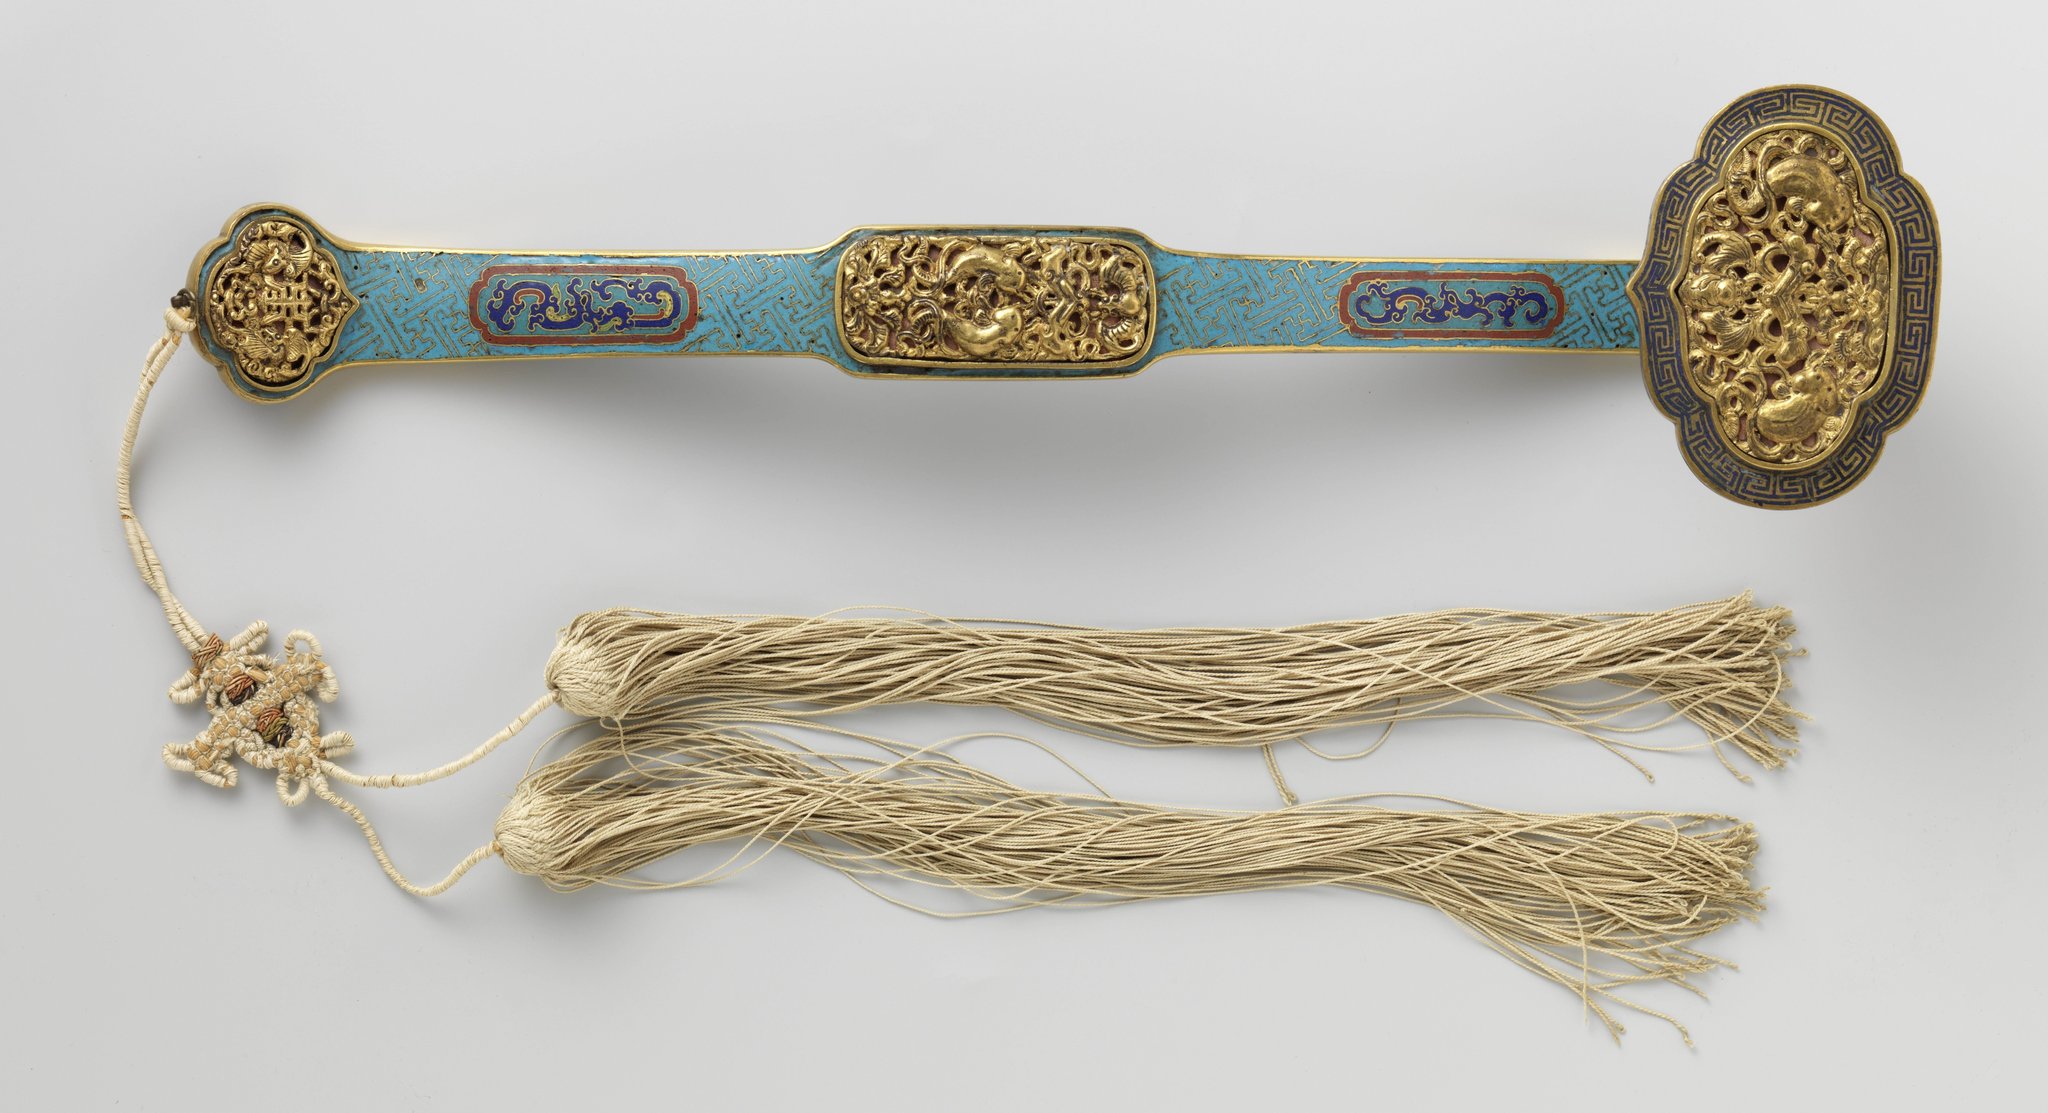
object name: scepter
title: Ruyi-shaped Sceptre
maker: Anonymous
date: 1700-1800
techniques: enamel, gilding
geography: china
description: Scepter, panelen in verguld repoussé, gedecoreerd met meervallen.